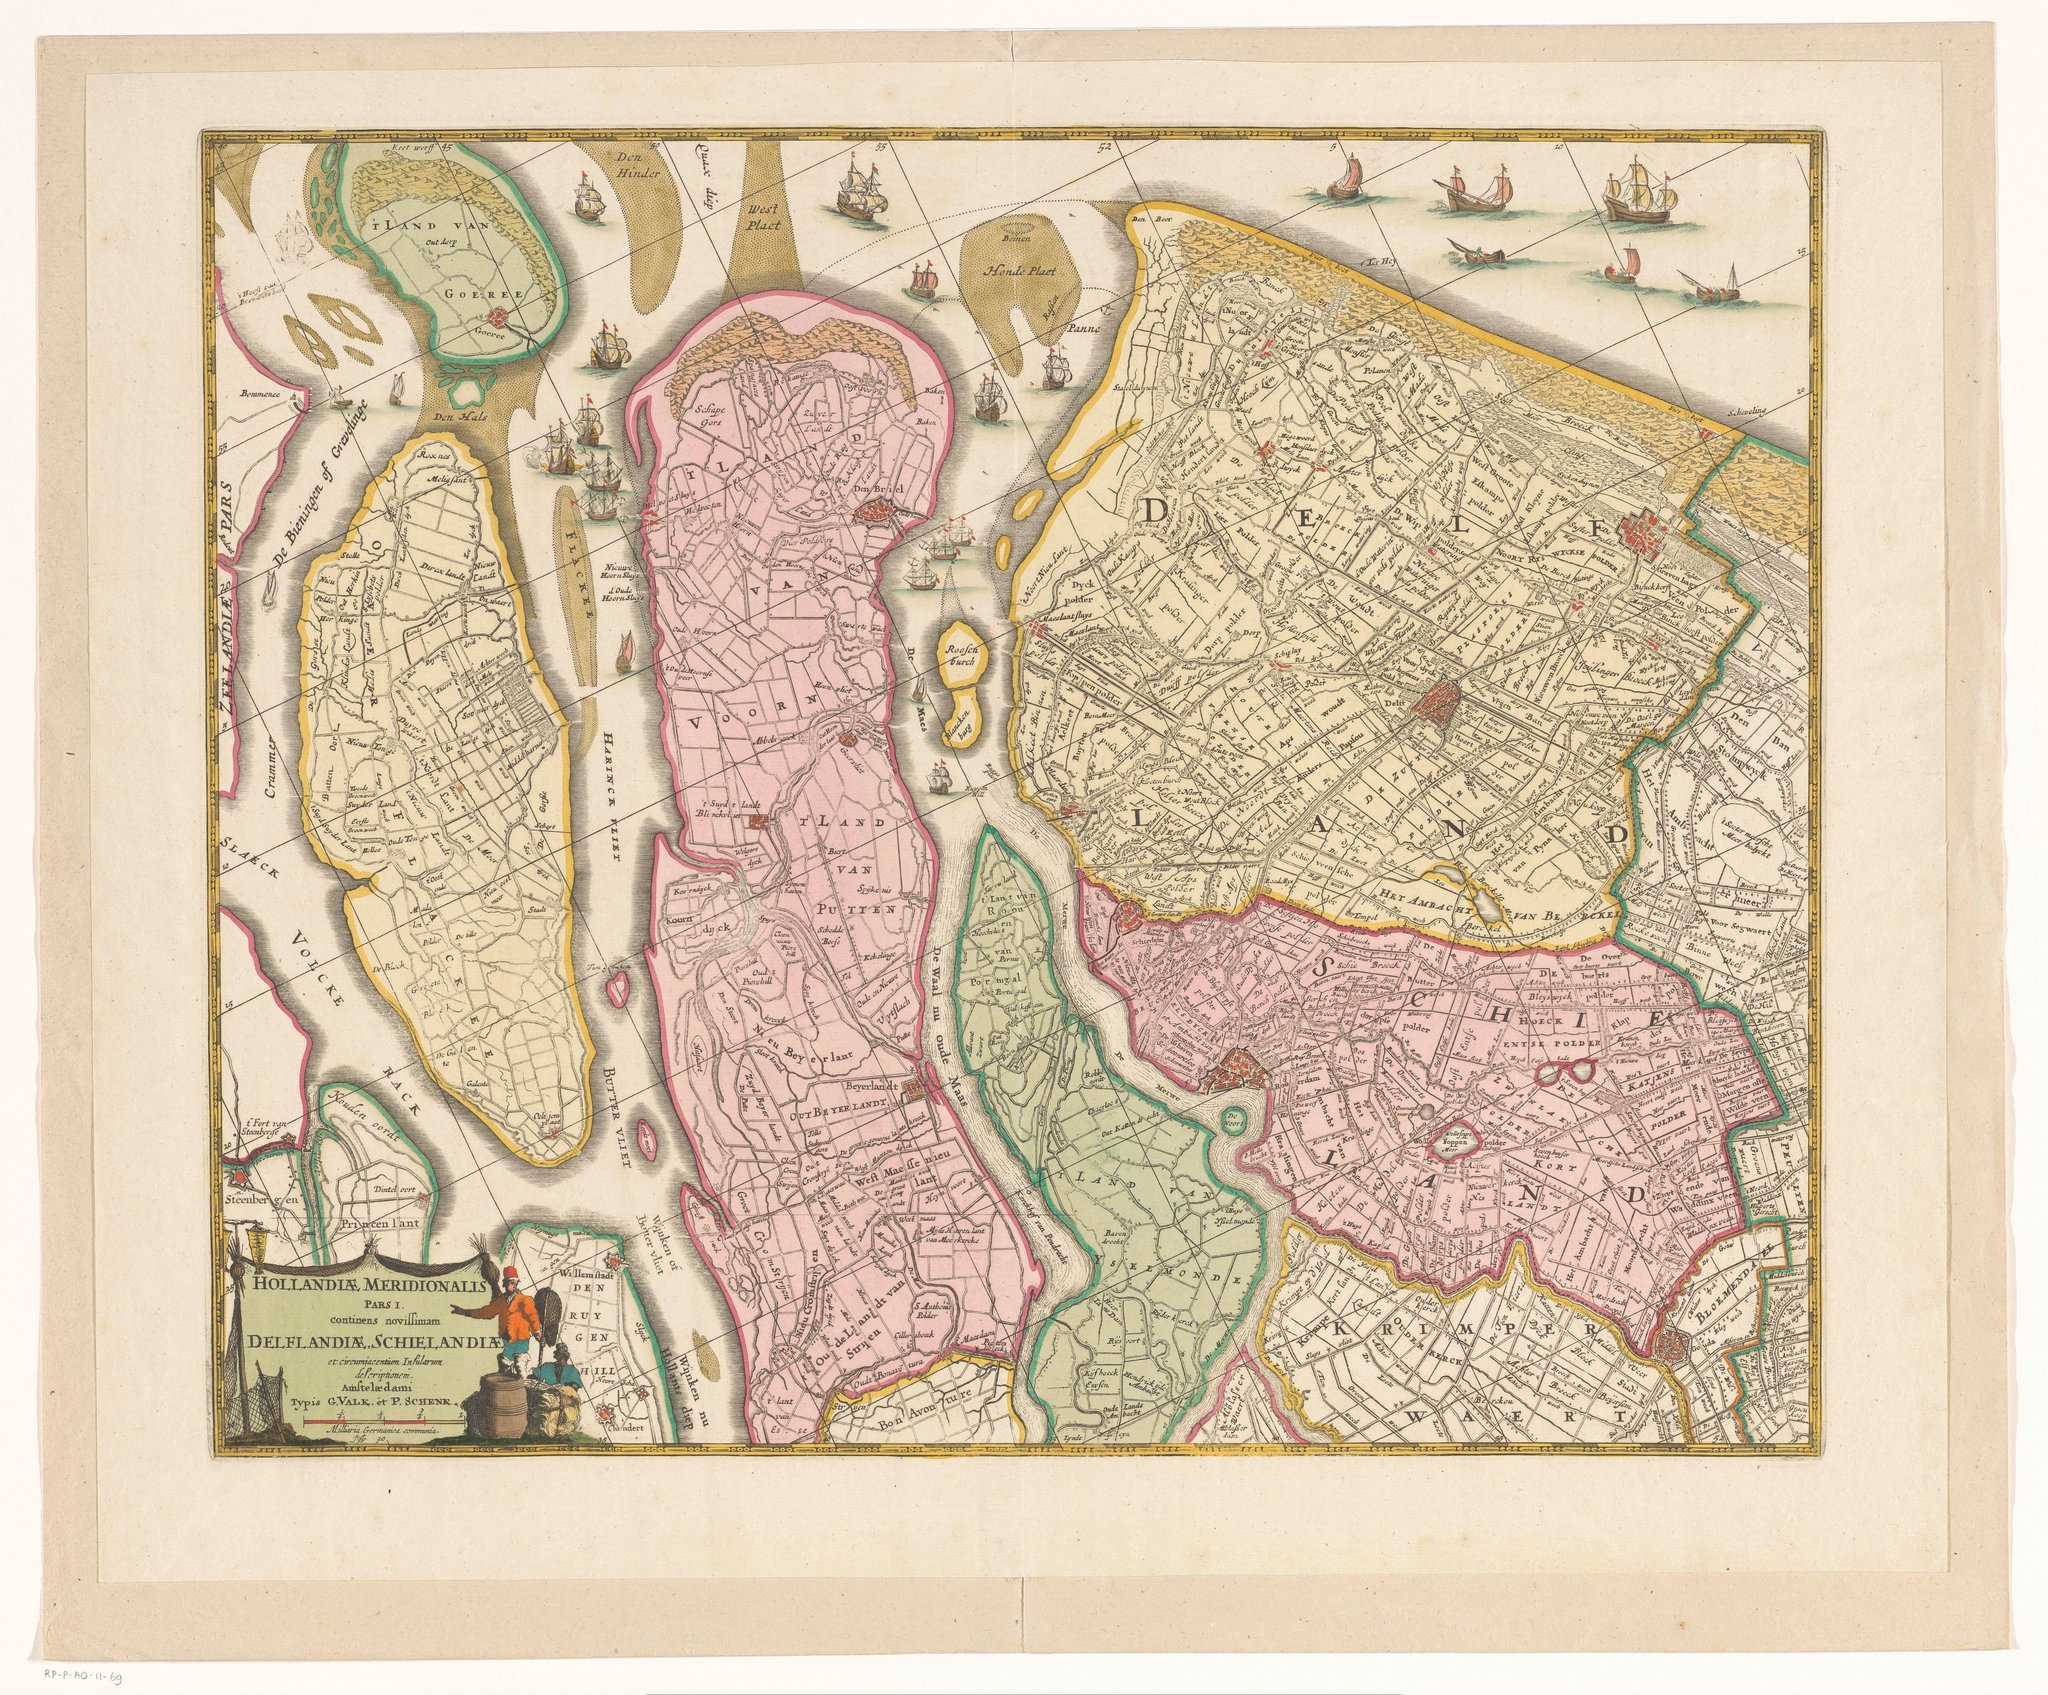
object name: print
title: Kaart van Delfland, Schieland en de Zuid-Hollandse eilanden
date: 1629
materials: paint, paper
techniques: brush, engraving, etching, hand coloring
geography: amsterdam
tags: maps of separate countries or regions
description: Kaart van Delfland, Schieland en de Zuid-Hollandse eilanden (onder andere Voorne, Overflakkee, Goeree en IJsselmonde). Linksonder een cartouche met de titel en een schaalstok: Milliaria Germanica communia. Voorzien van een coördinatennet. Oriëntatie: noorden rechts.